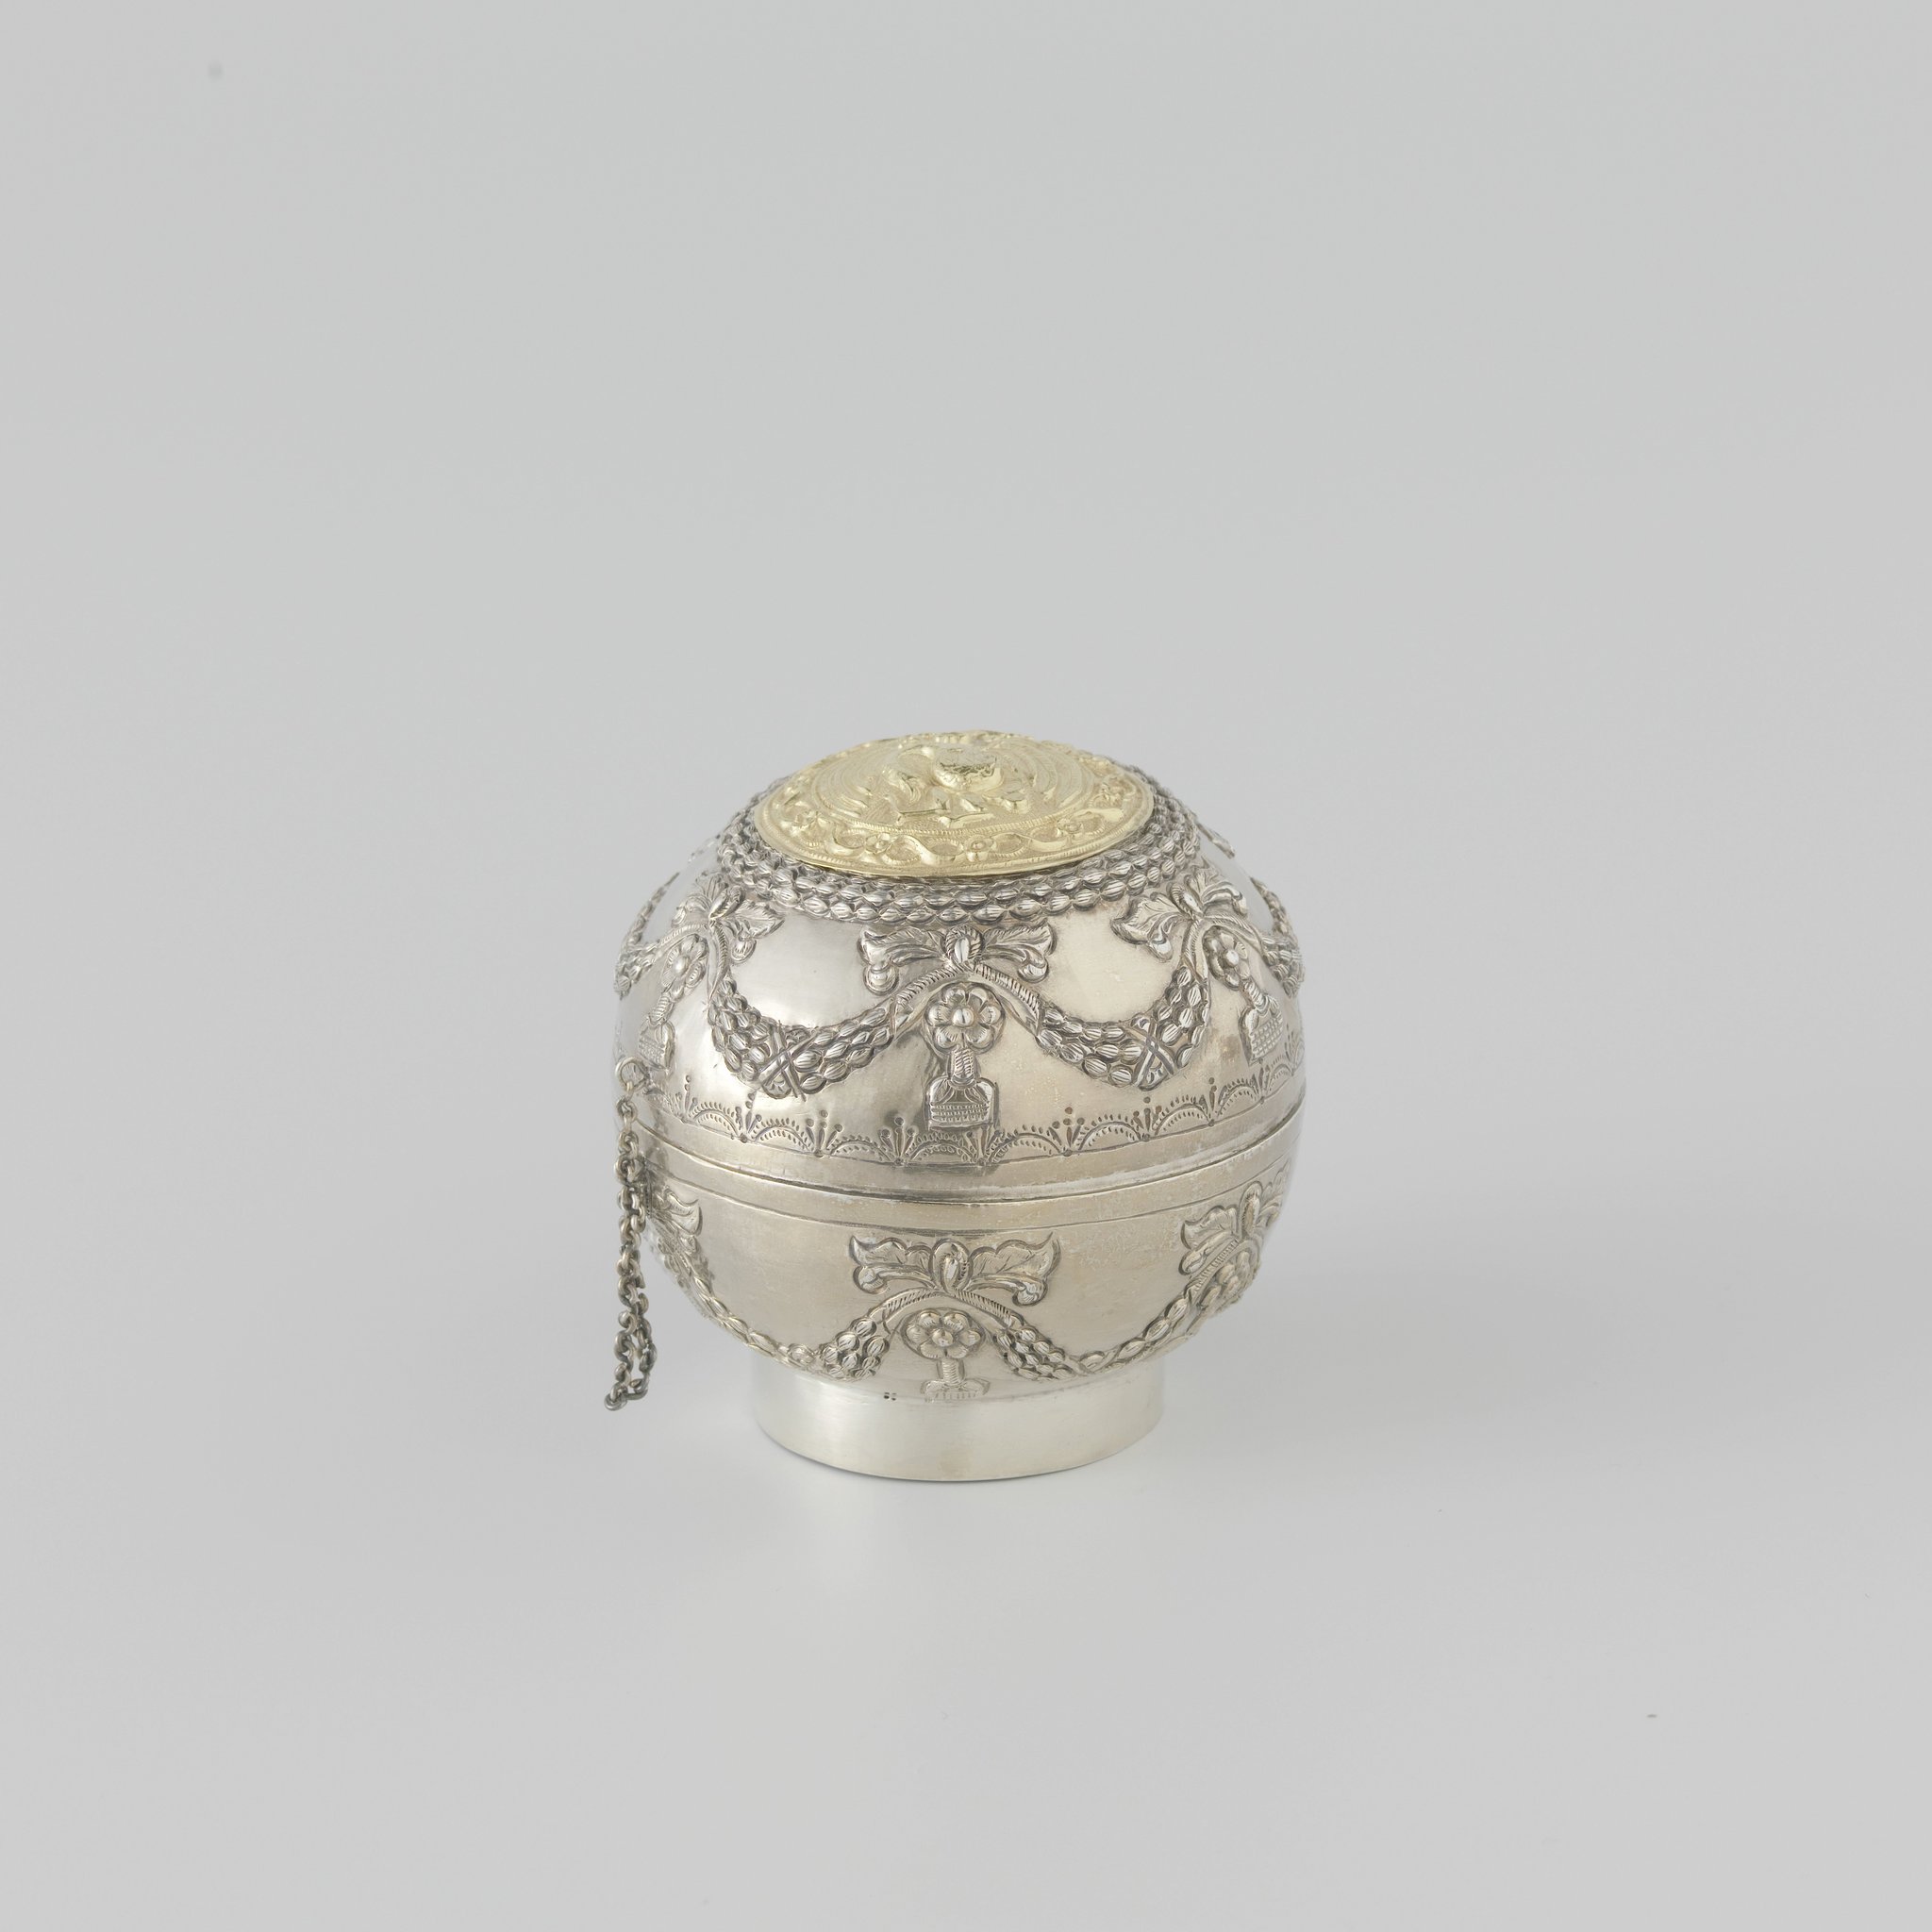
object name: pot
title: Sirih box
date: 1700-1799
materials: gold, silver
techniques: gilding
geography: indonesia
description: Two sirih boxes. Silver. Batavia (?), c. 1770 - 1790. A quid of sirih (betel) comprises areca nut, gambir and lime wrapped in a betel leaf. Chewing sirih was popular throughout Southeast Asia. Purchased from Stichting Cultuurgeschiedenis Nederlanders Overzee.